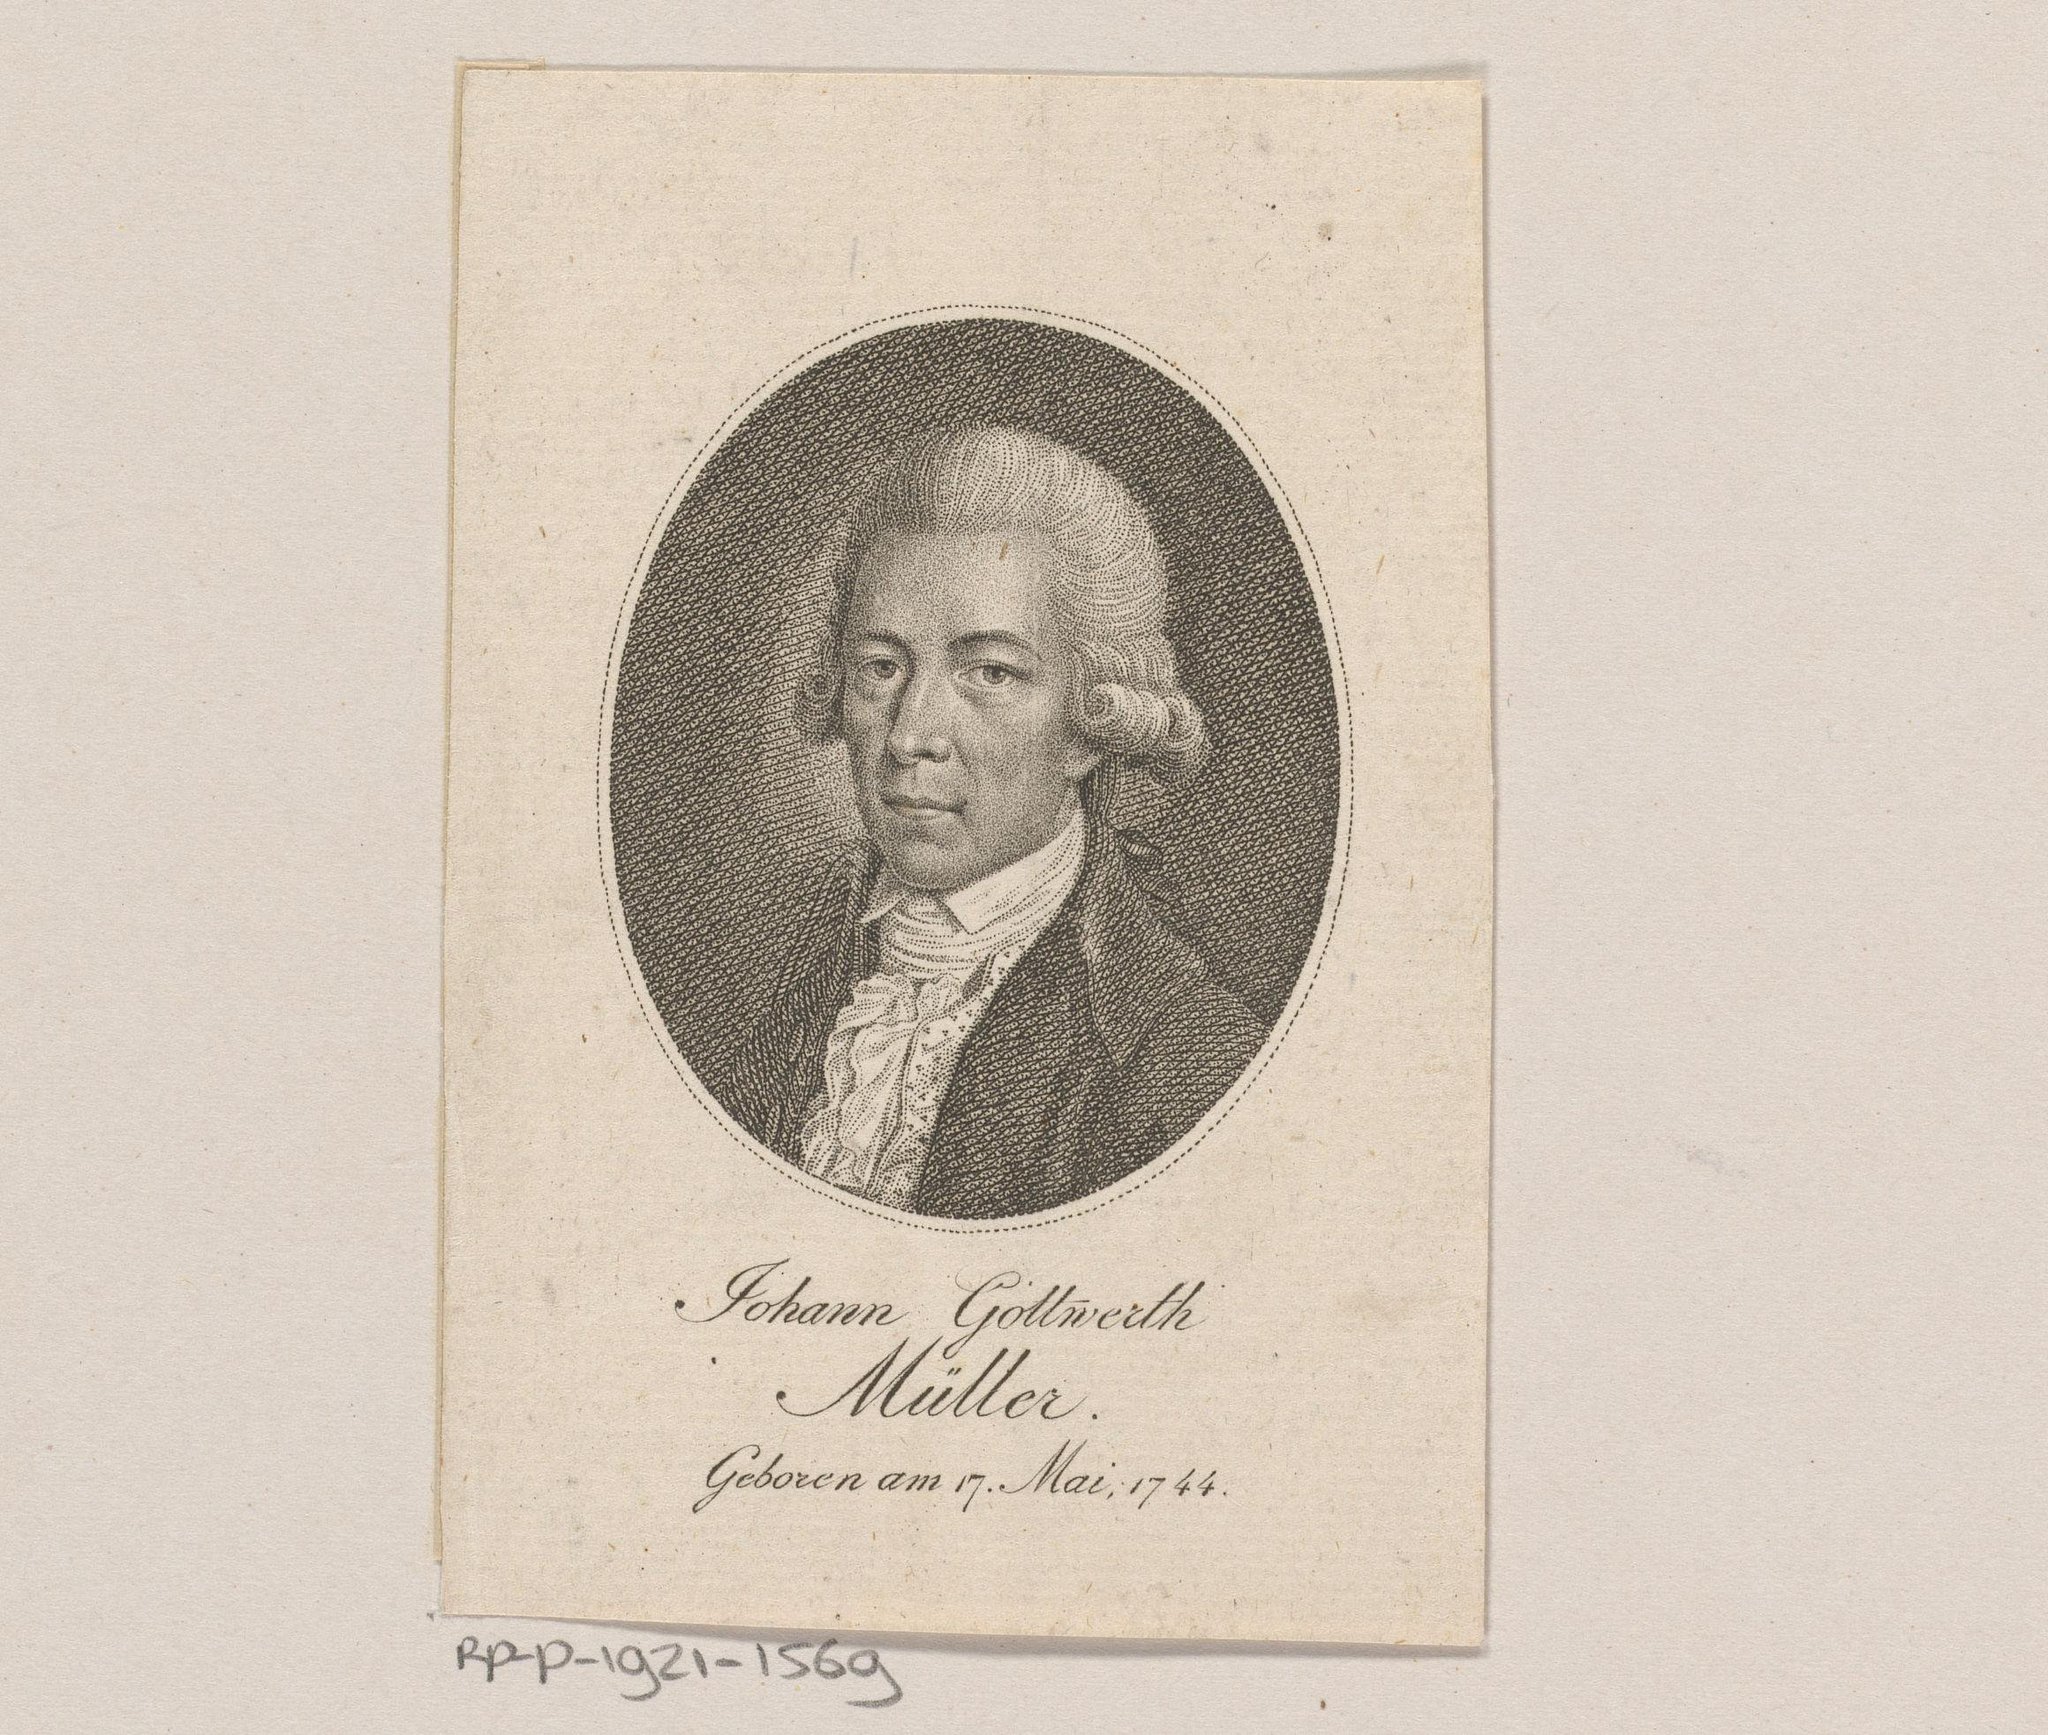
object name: print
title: Portret van Johann Gottwerth Müller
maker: Anonymous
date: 1783-1828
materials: paper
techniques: engraving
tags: historical persons, portrait of a writer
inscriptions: collector's mark: Lugt 2233